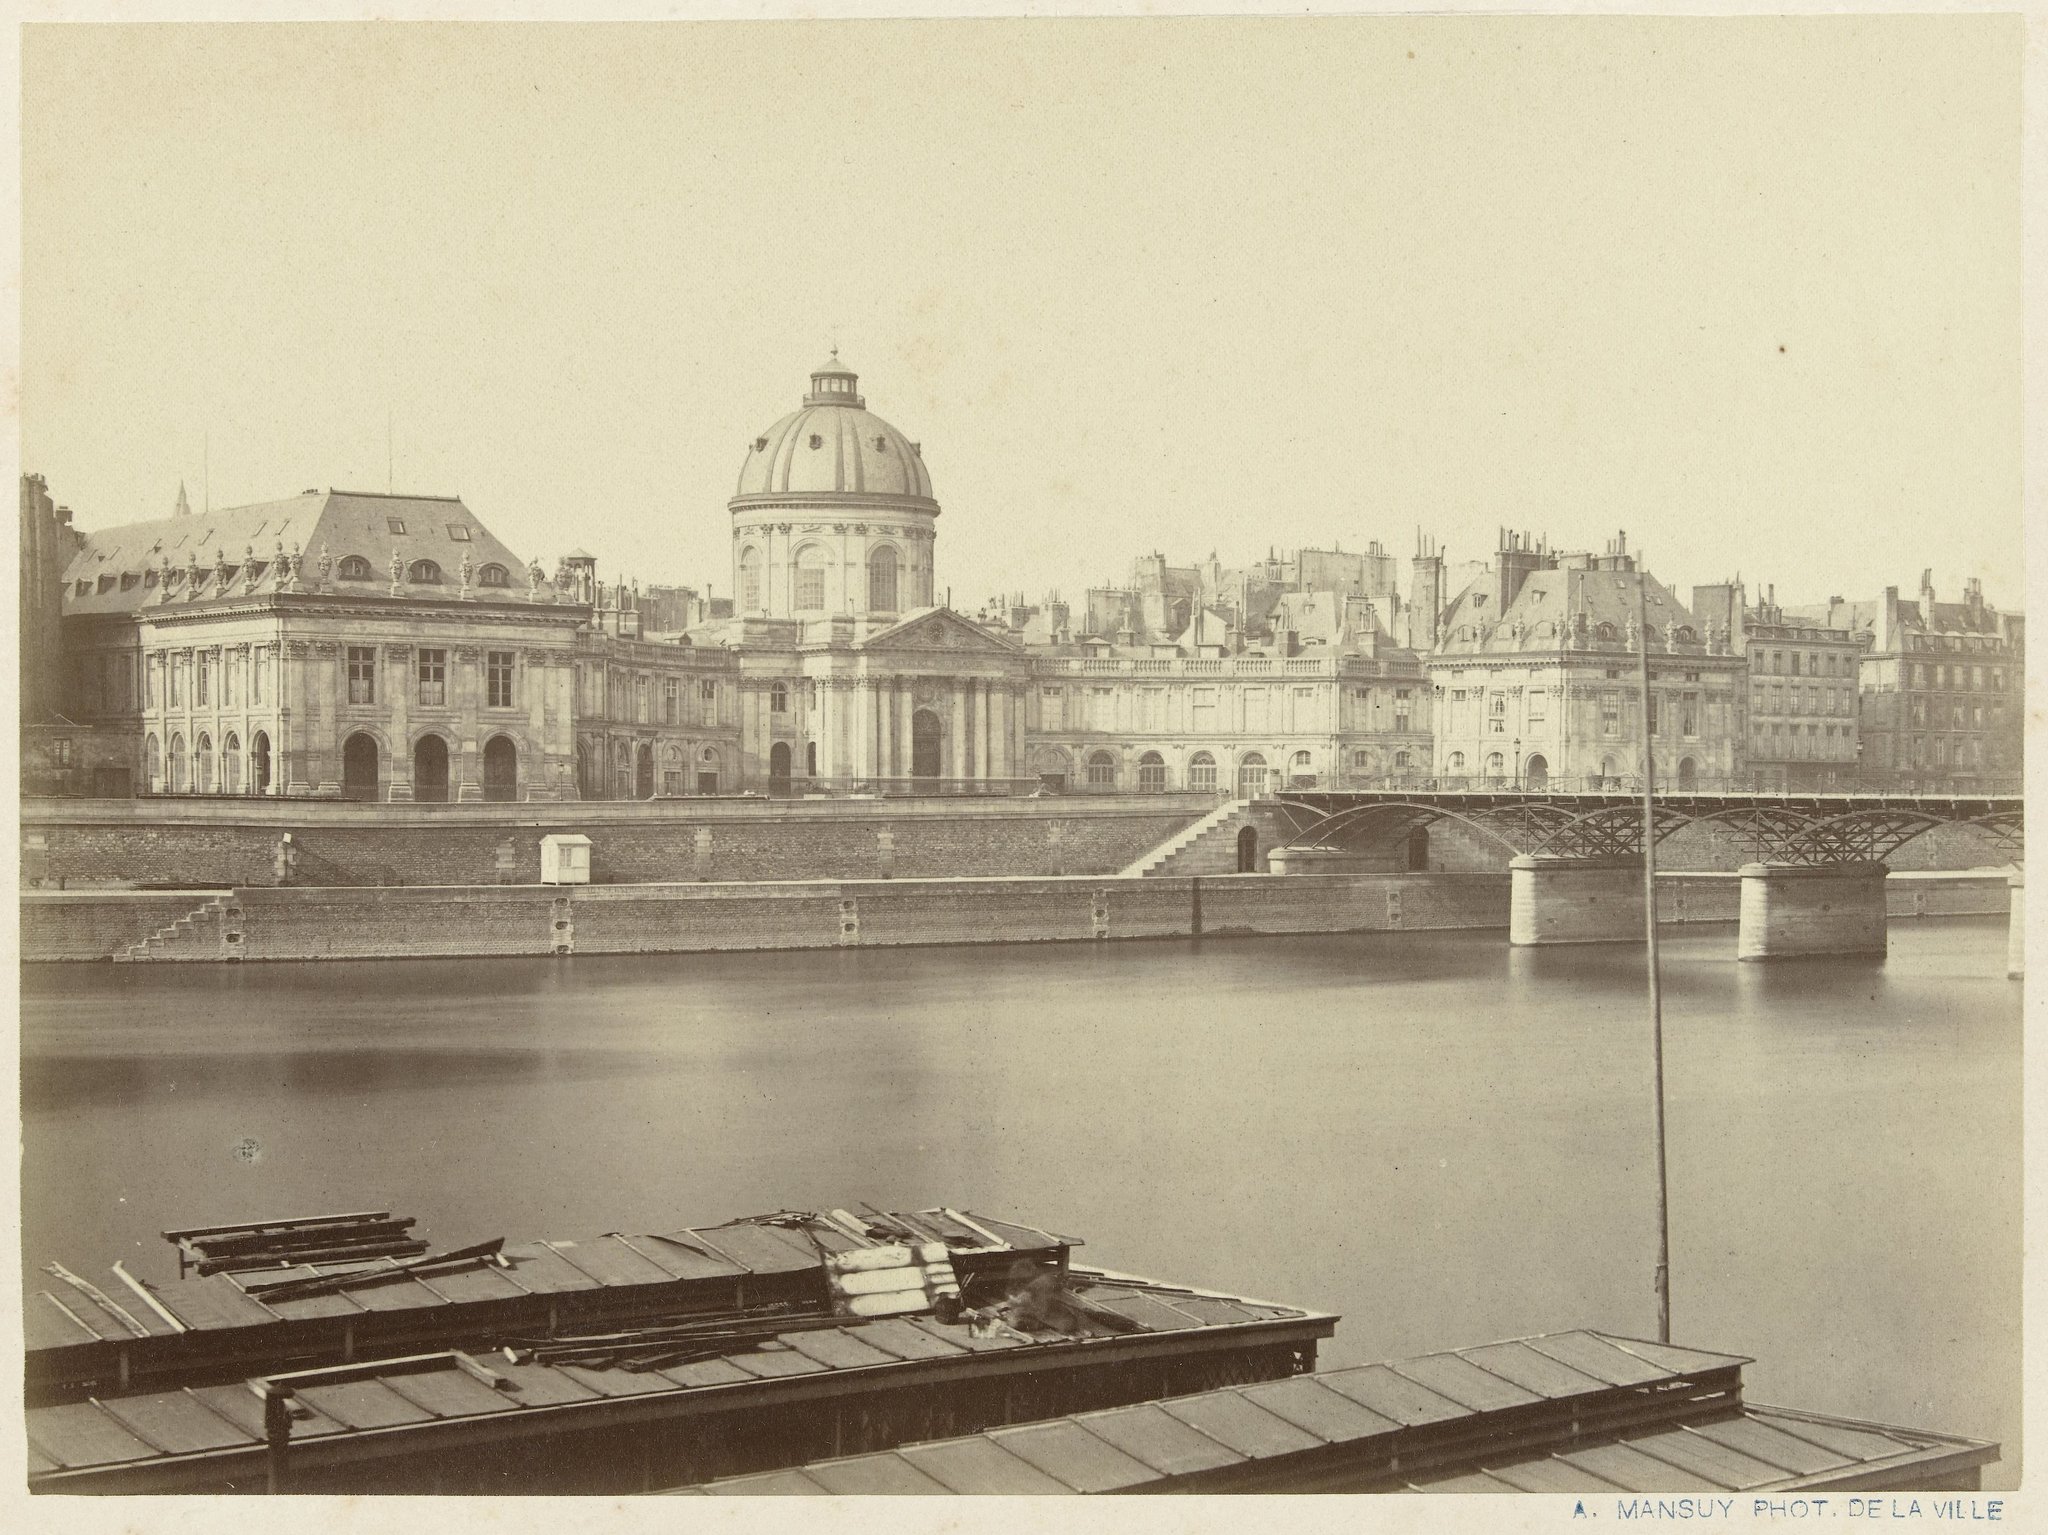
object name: photograph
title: Gezicht op het Palais de l'Institut en de Pont des Arts over de Seine te Parijs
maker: albert mansuy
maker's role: fotograaf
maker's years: 1831-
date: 1860-1880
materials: cardboard, paper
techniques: albumen print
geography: paris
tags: exterior ~ representation of a building, bridge in city across river, canal, etc.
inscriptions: stamp: ‘14’, inscription: ‘Palais de l'Institut’